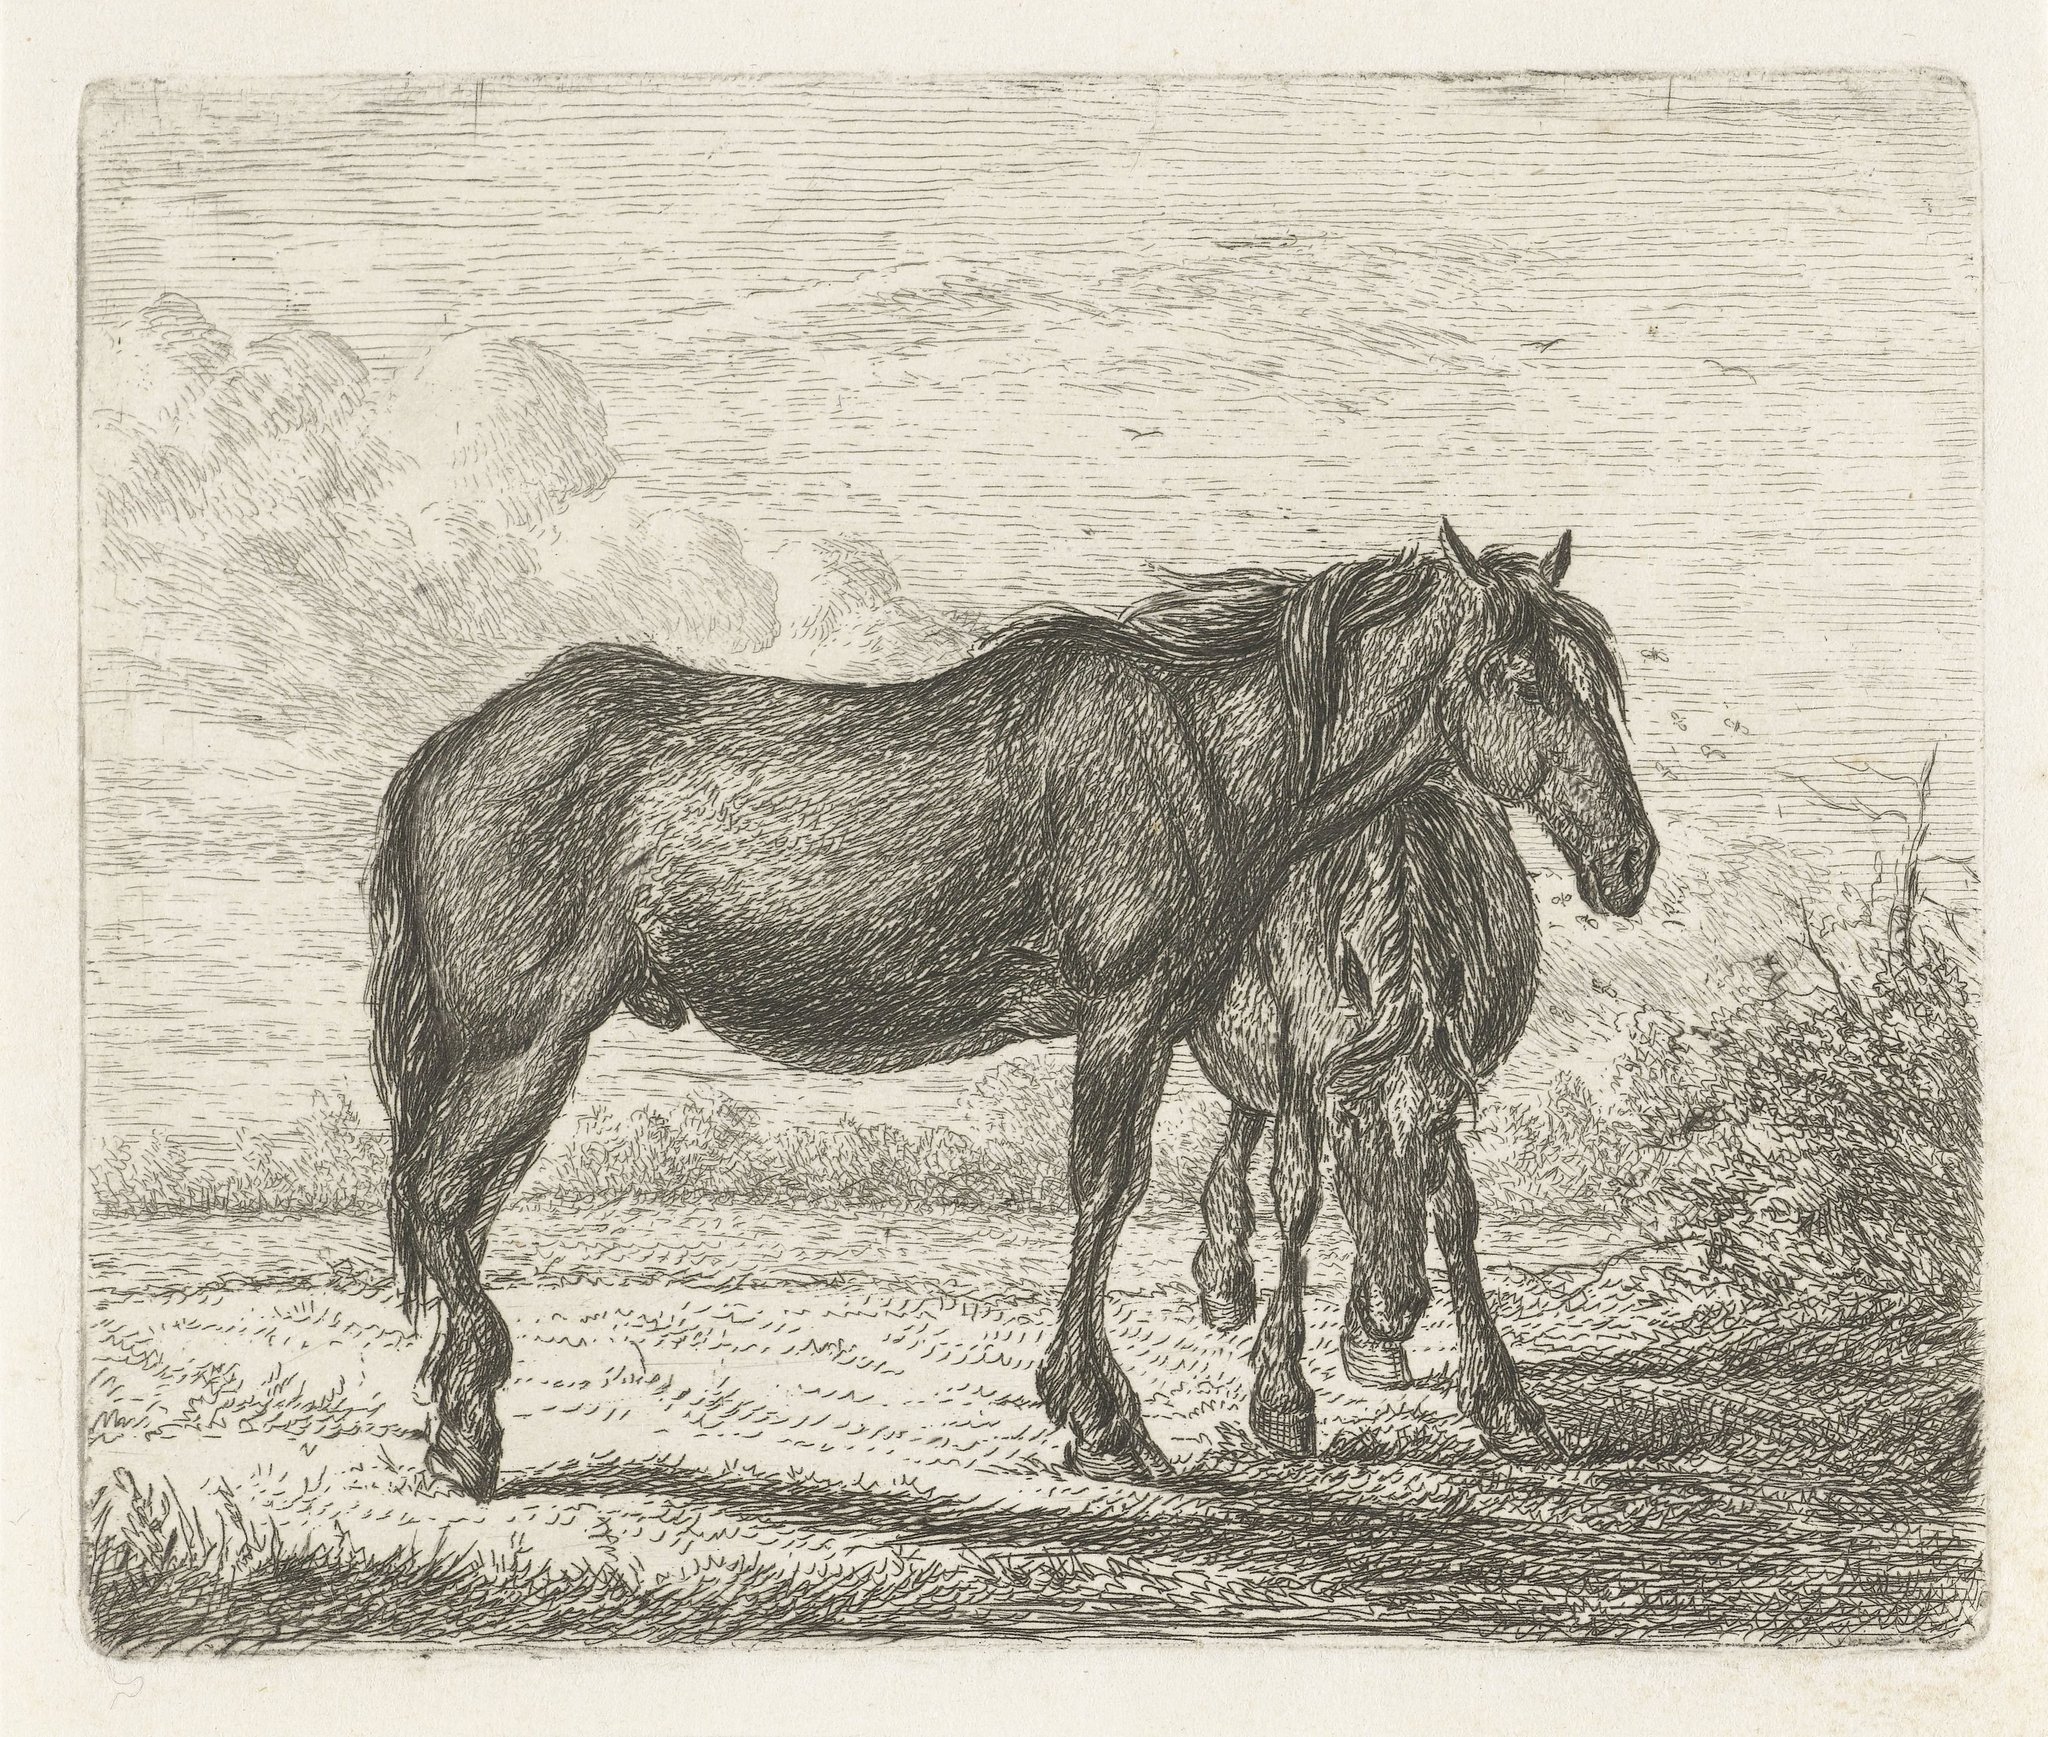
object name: print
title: Twee paarden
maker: jacobus cornelis gaal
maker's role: print maker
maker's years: 1796-1866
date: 1851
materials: paper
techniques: etching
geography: netherlands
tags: horse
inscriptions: collector's mark: Lugt 2228